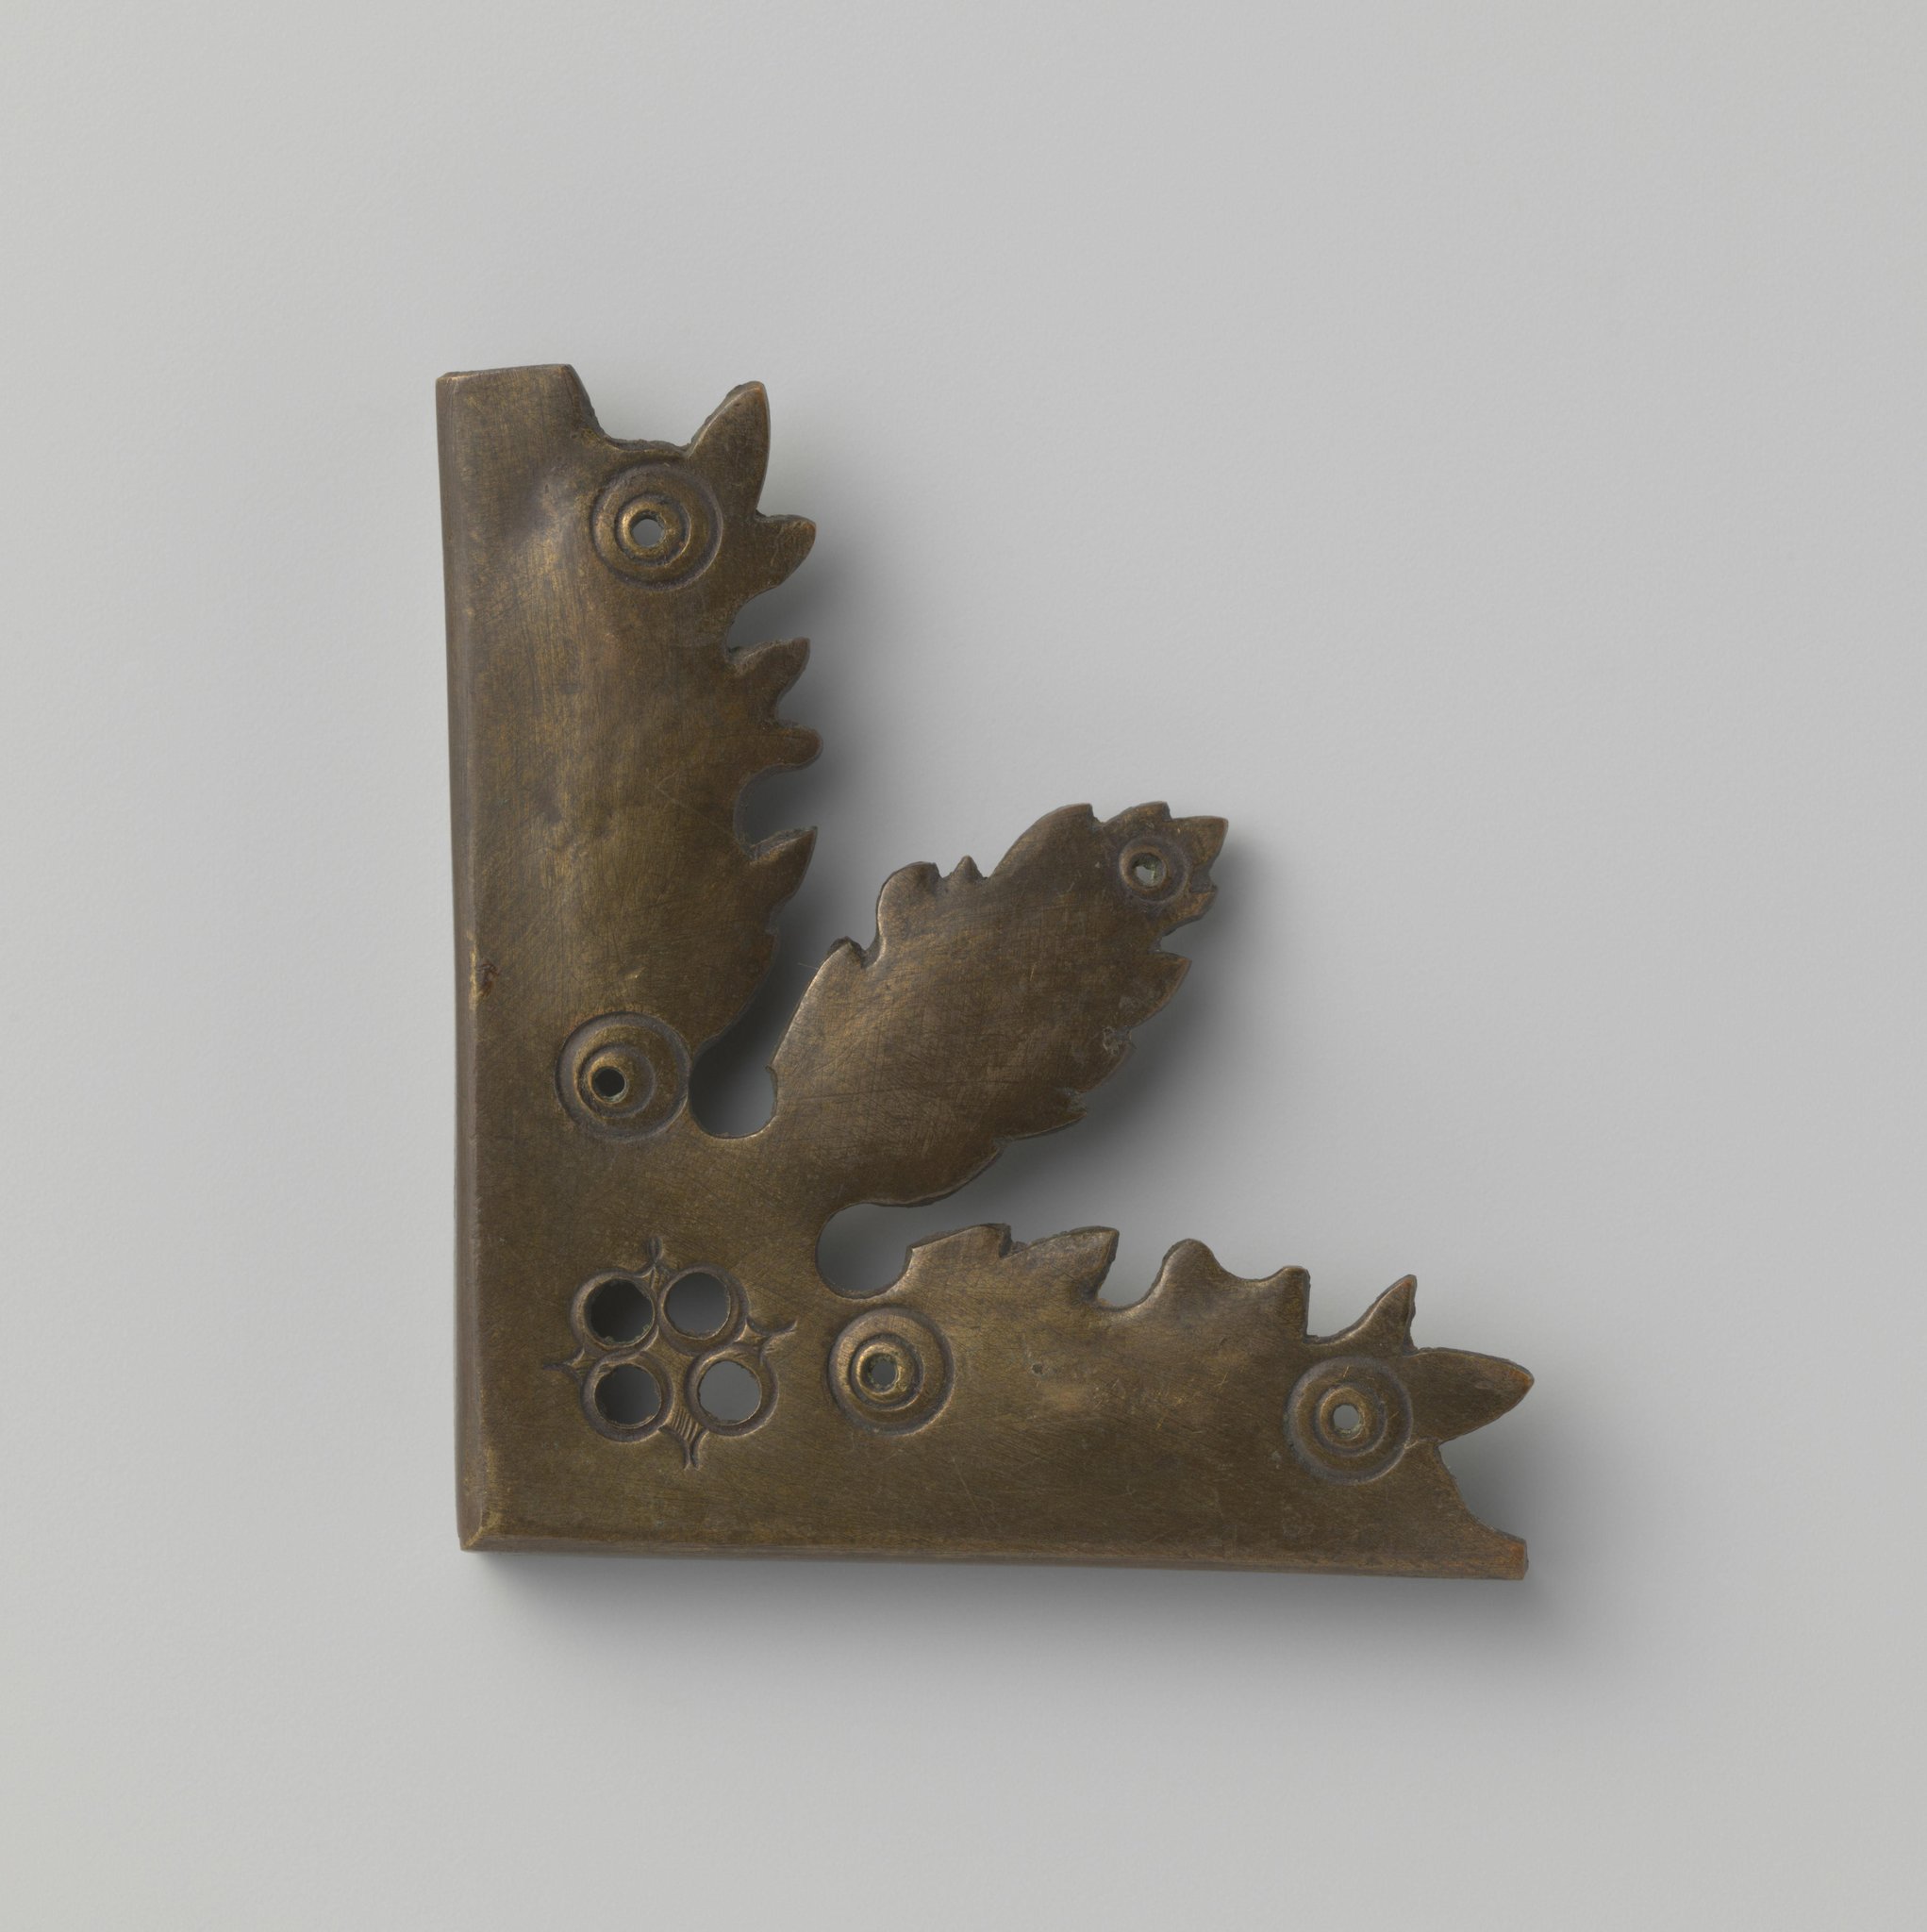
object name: binding finishing hardware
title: Hoekstuk van een boekbeslag (?)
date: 1400-1950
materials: brass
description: Hoekstuk van een boekbeslag (?) van messing.